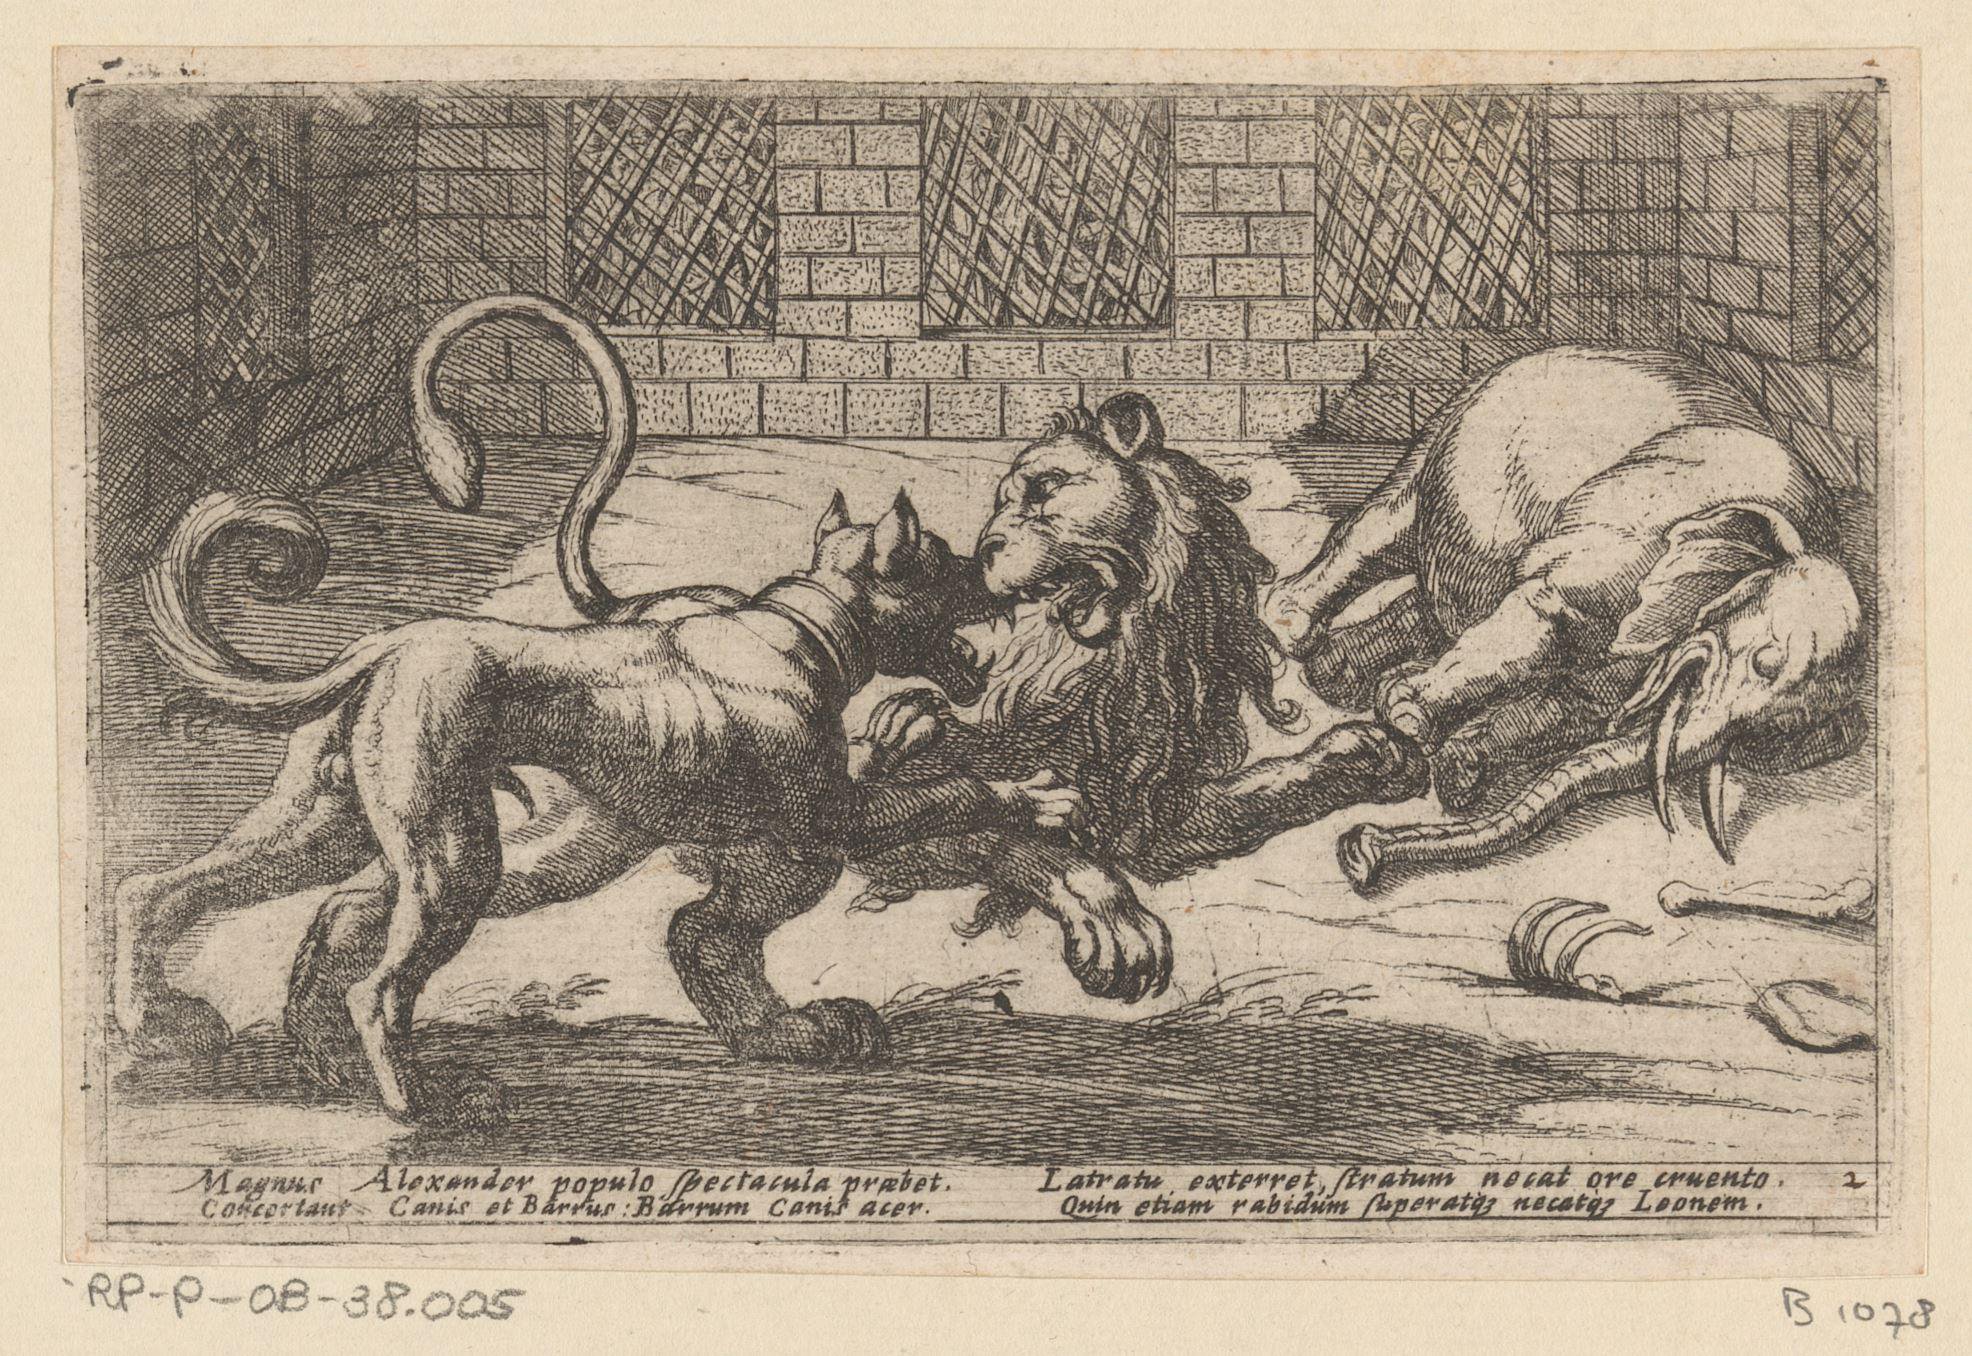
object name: print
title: Venationes Ferarum, Avium, Piscium Pugnae bestiariorum: et mutuae bestiarum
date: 1602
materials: paper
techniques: etching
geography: italy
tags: man and animal (+ animal cage), beasts of prey, predatory animals: lion, trunked animals: elephant, dog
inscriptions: number: ‘2’, collector's mark: Lugt 240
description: Gezicht in een kooi met een dode olifant en een vechtende hond en leeuw. Tekst in het Latijn in ondermarge.